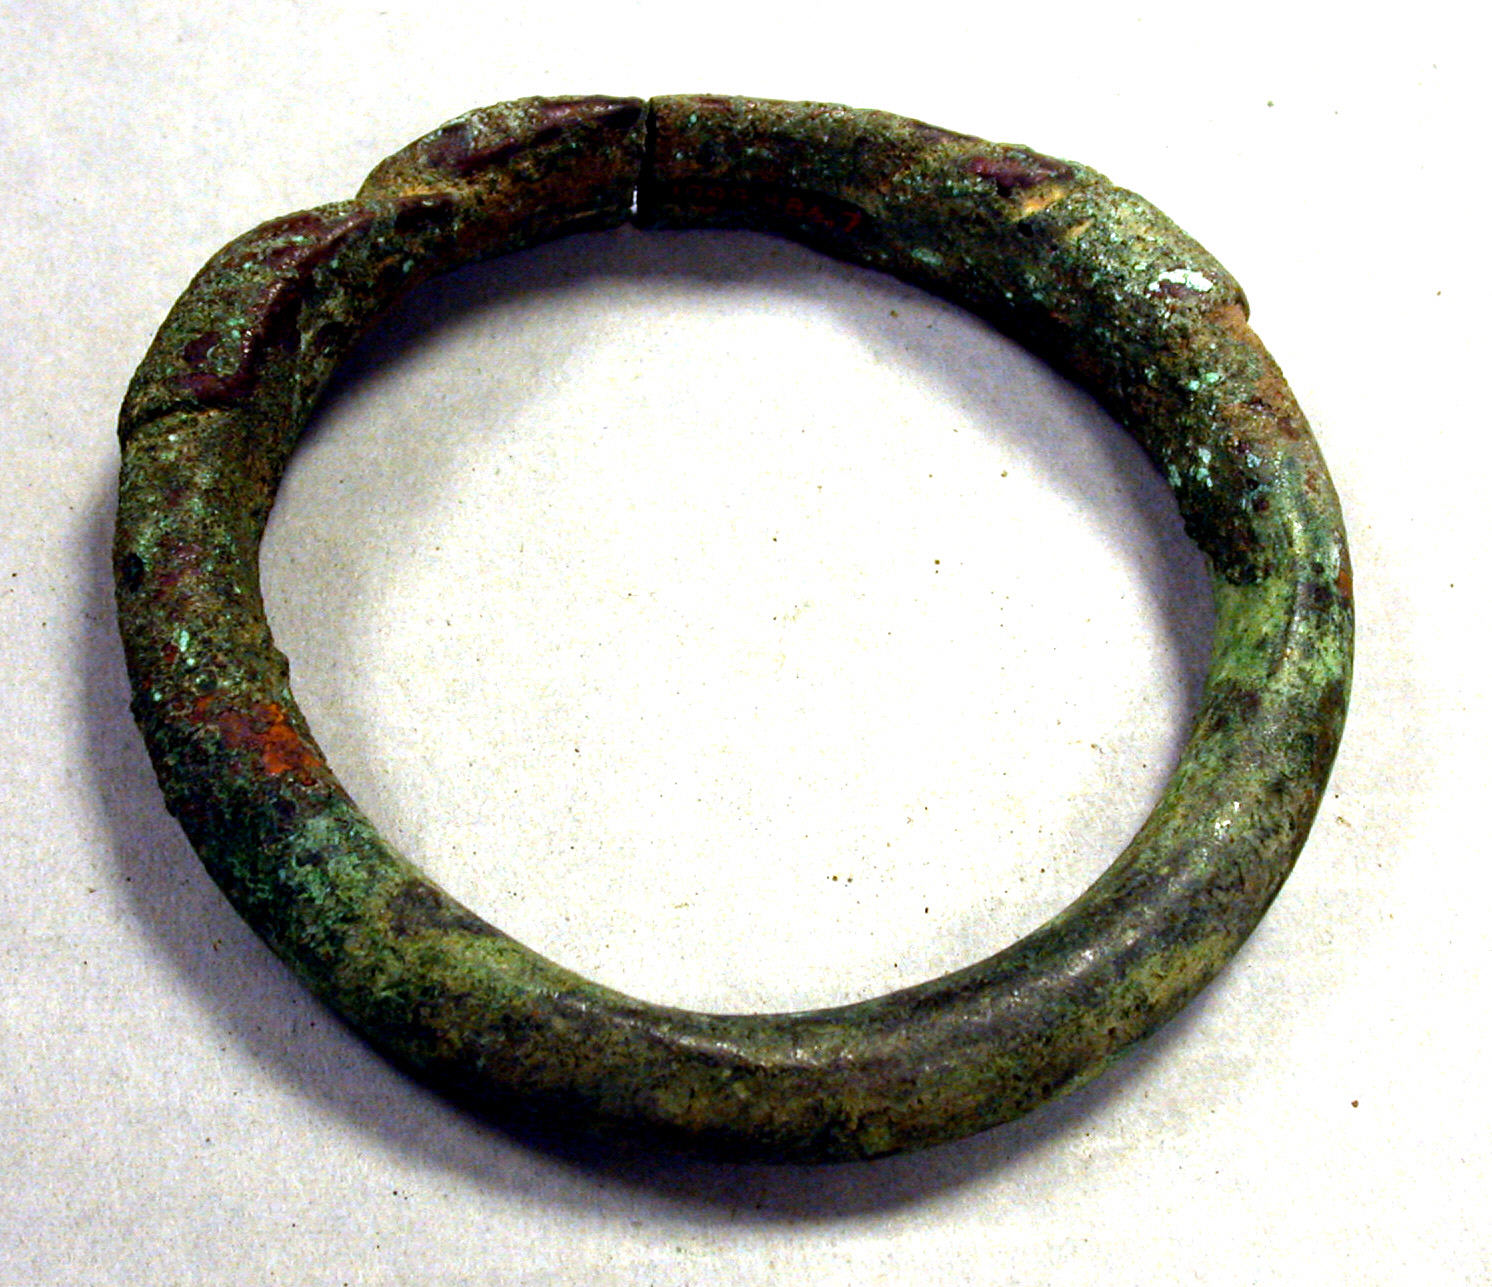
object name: bracelet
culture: middle niger civilization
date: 1001-1600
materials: copper alloy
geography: mali